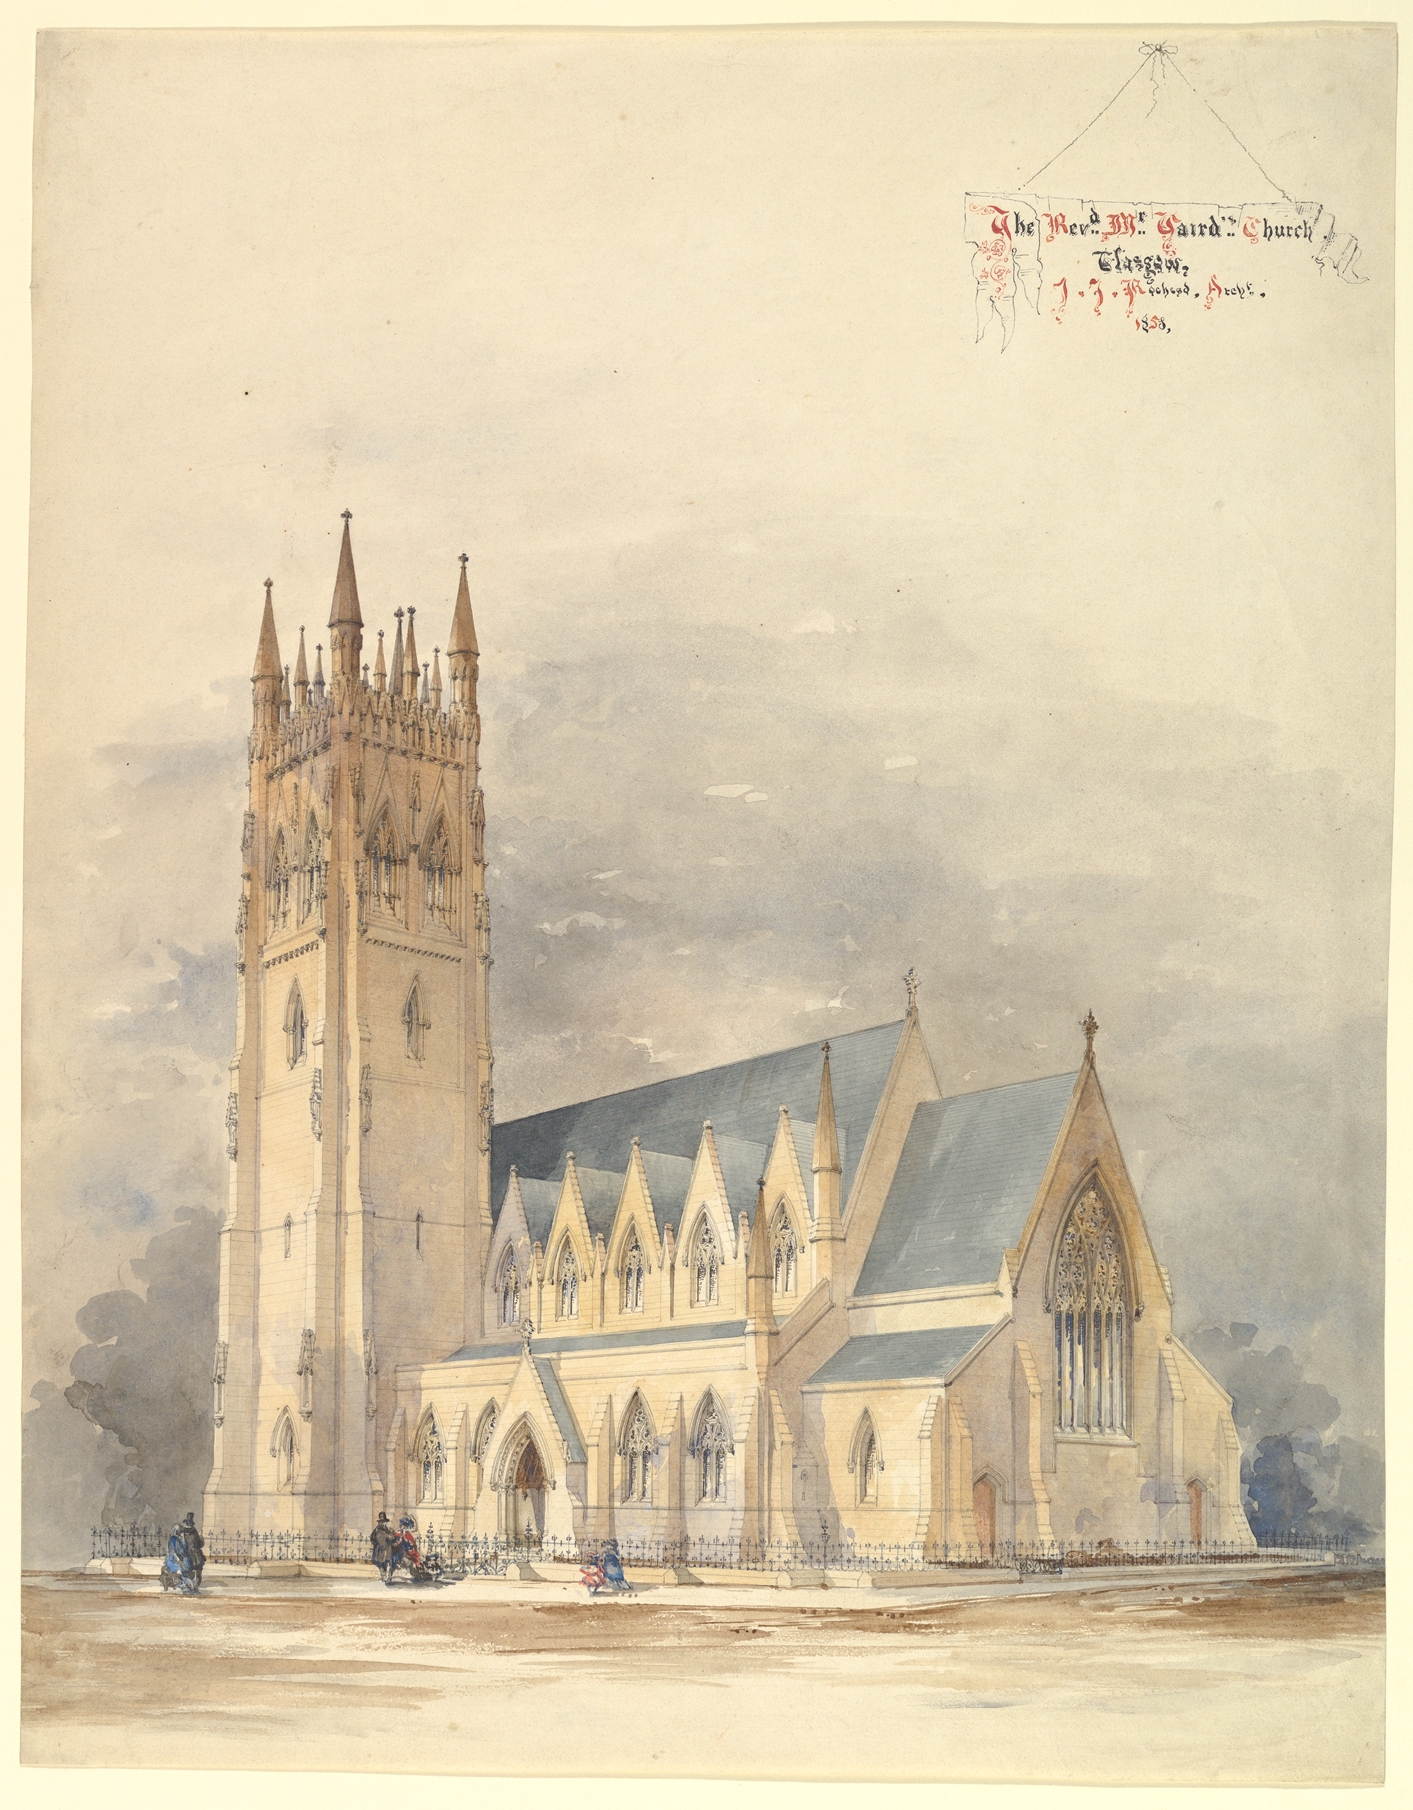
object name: drawing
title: Perspective Elevation of Reverend Mr. Gaird's Church, Glasgow, in the Gothic Style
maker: j. t. rochead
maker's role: architect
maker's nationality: british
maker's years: 1814-1878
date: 1858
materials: ink, watercolor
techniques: pen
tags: churches